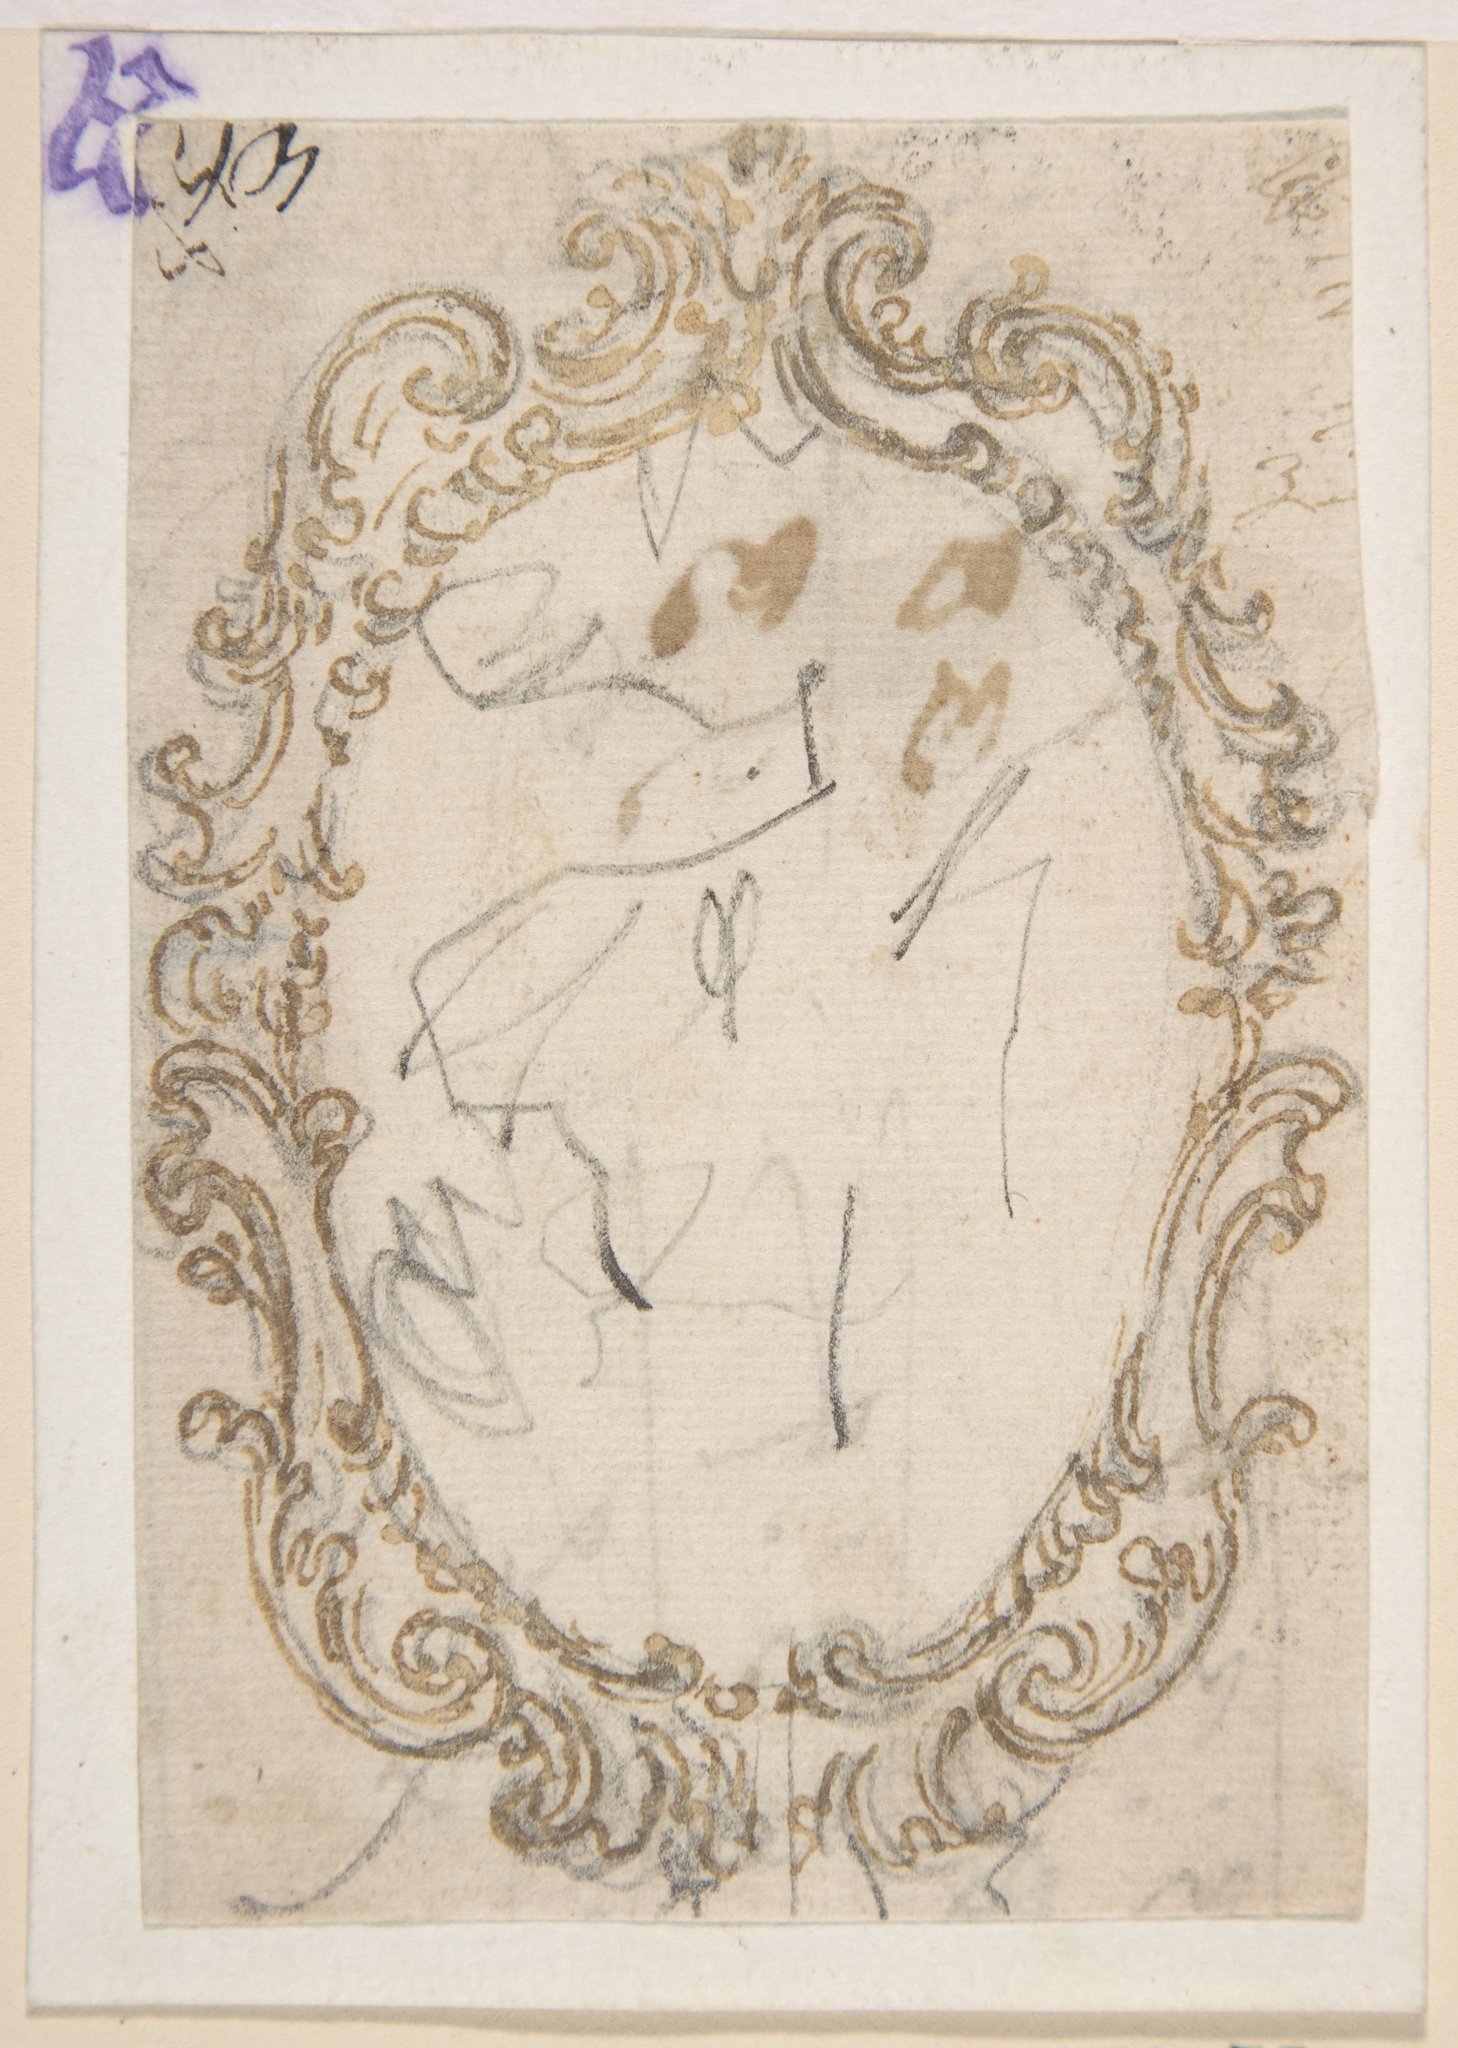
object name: drawing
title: Design for a Cartouche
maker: giovanni battista foggini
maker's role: artist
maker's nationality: italian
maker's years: 1652-1725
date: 1672-1725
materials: chalk, ink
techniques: pen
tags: cartouches